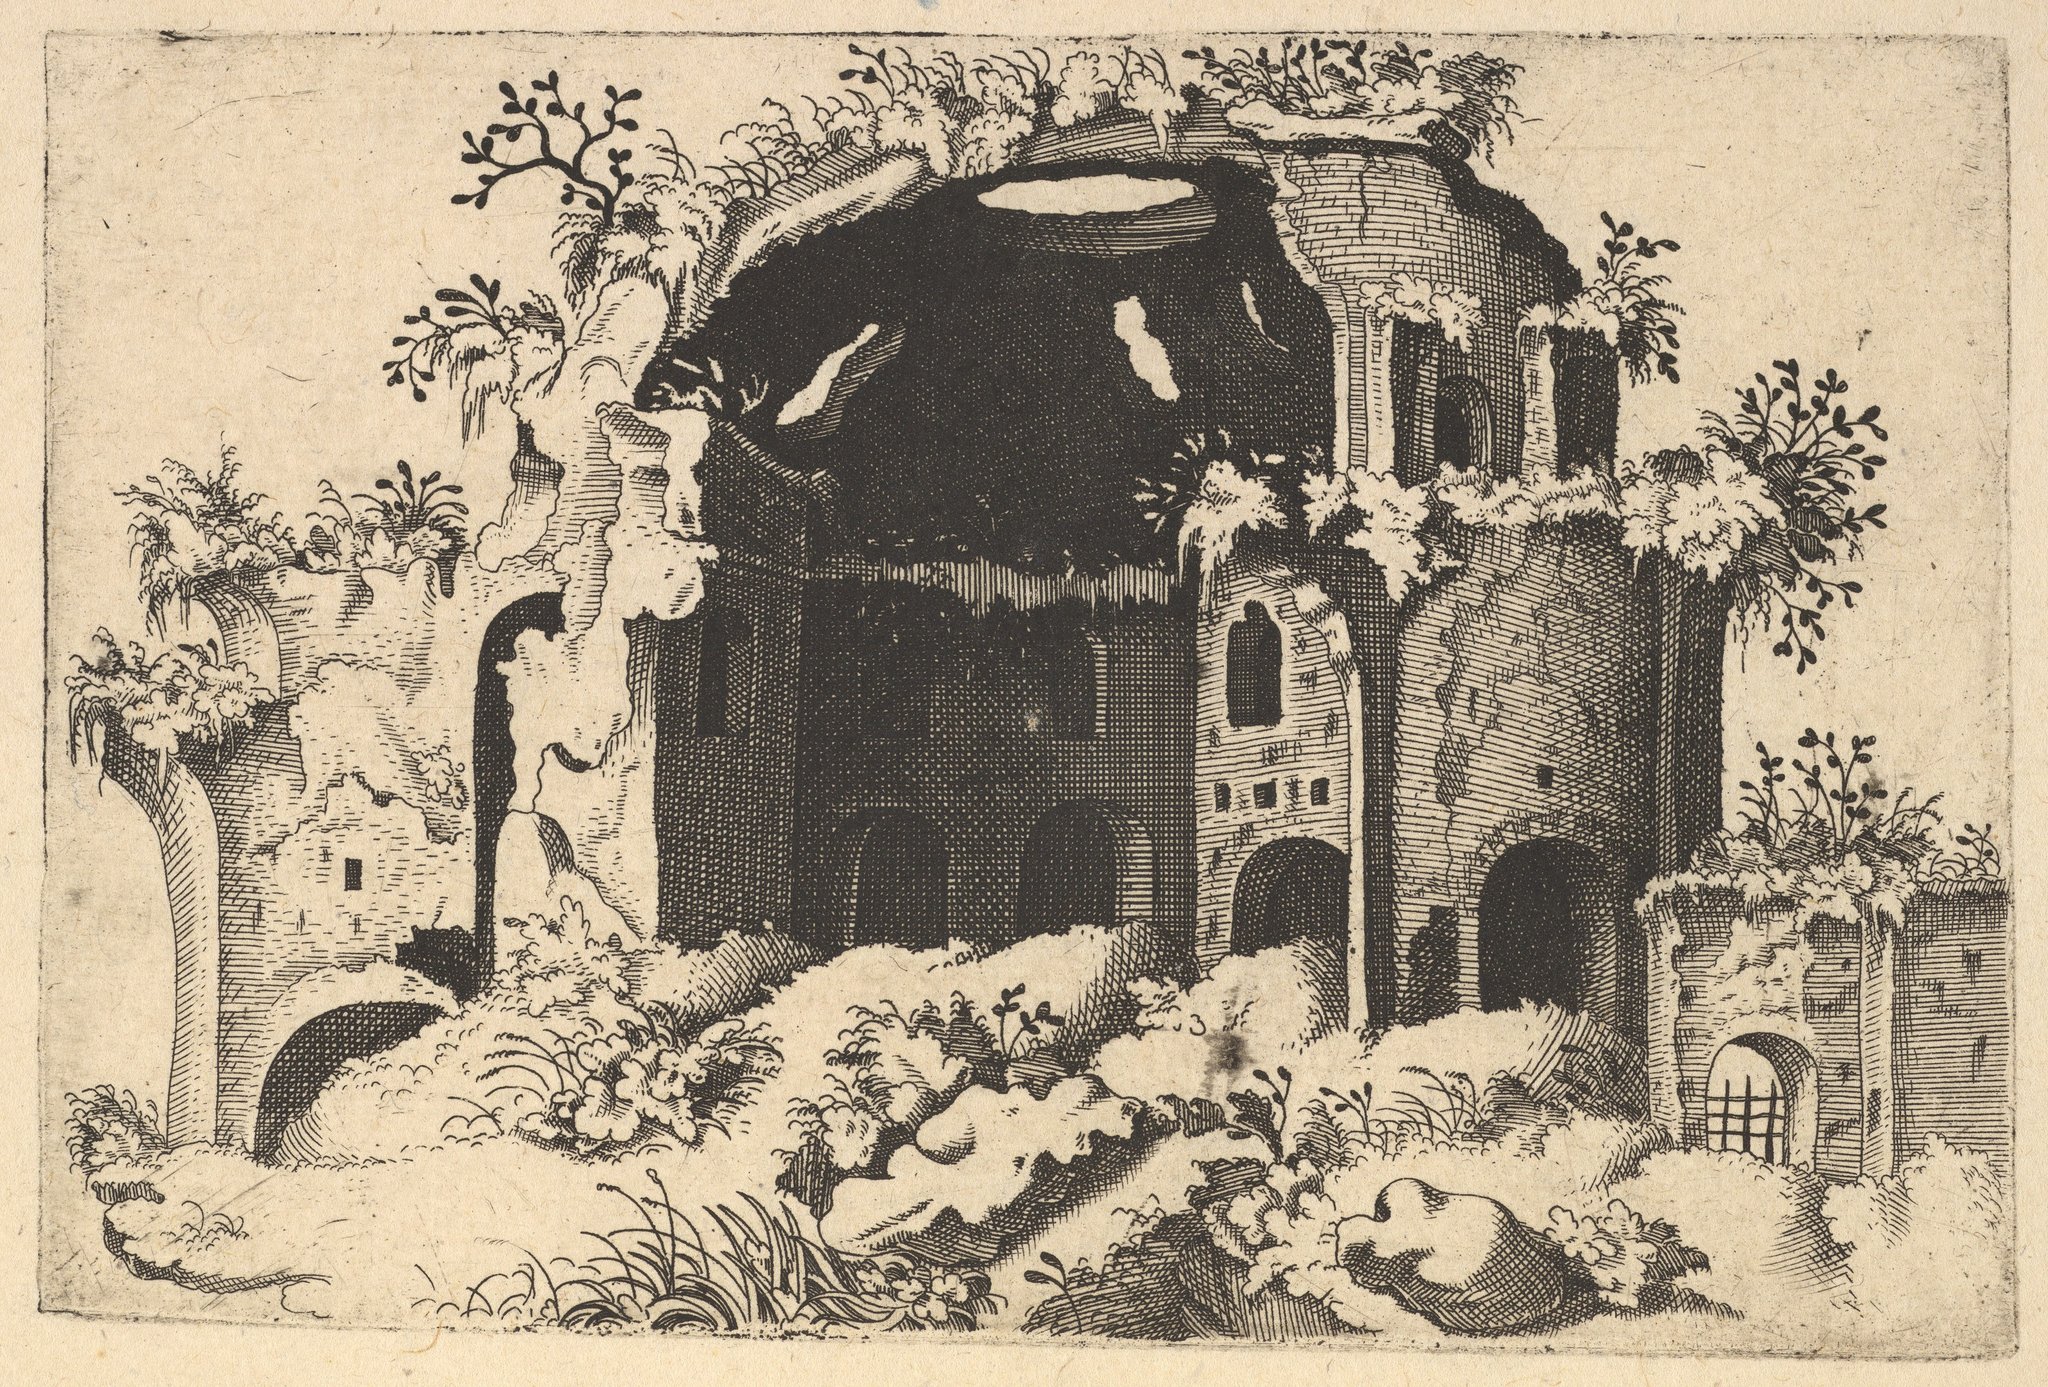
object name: book print ornament architecture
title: Horizontal Landscape with the remains of the Nymphaeum, mistakenly identified as the Temple of Minerva Medica in Rome, from the series 'Ruinarum variarum fabricarum delineationes pictoribus caeterisque id genus artificibus multum utiles'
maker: lambert suavius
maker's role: artist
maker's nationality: netherlandish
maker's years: 1510-1576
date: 1554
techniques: etching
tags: ruins,landscapes,plants